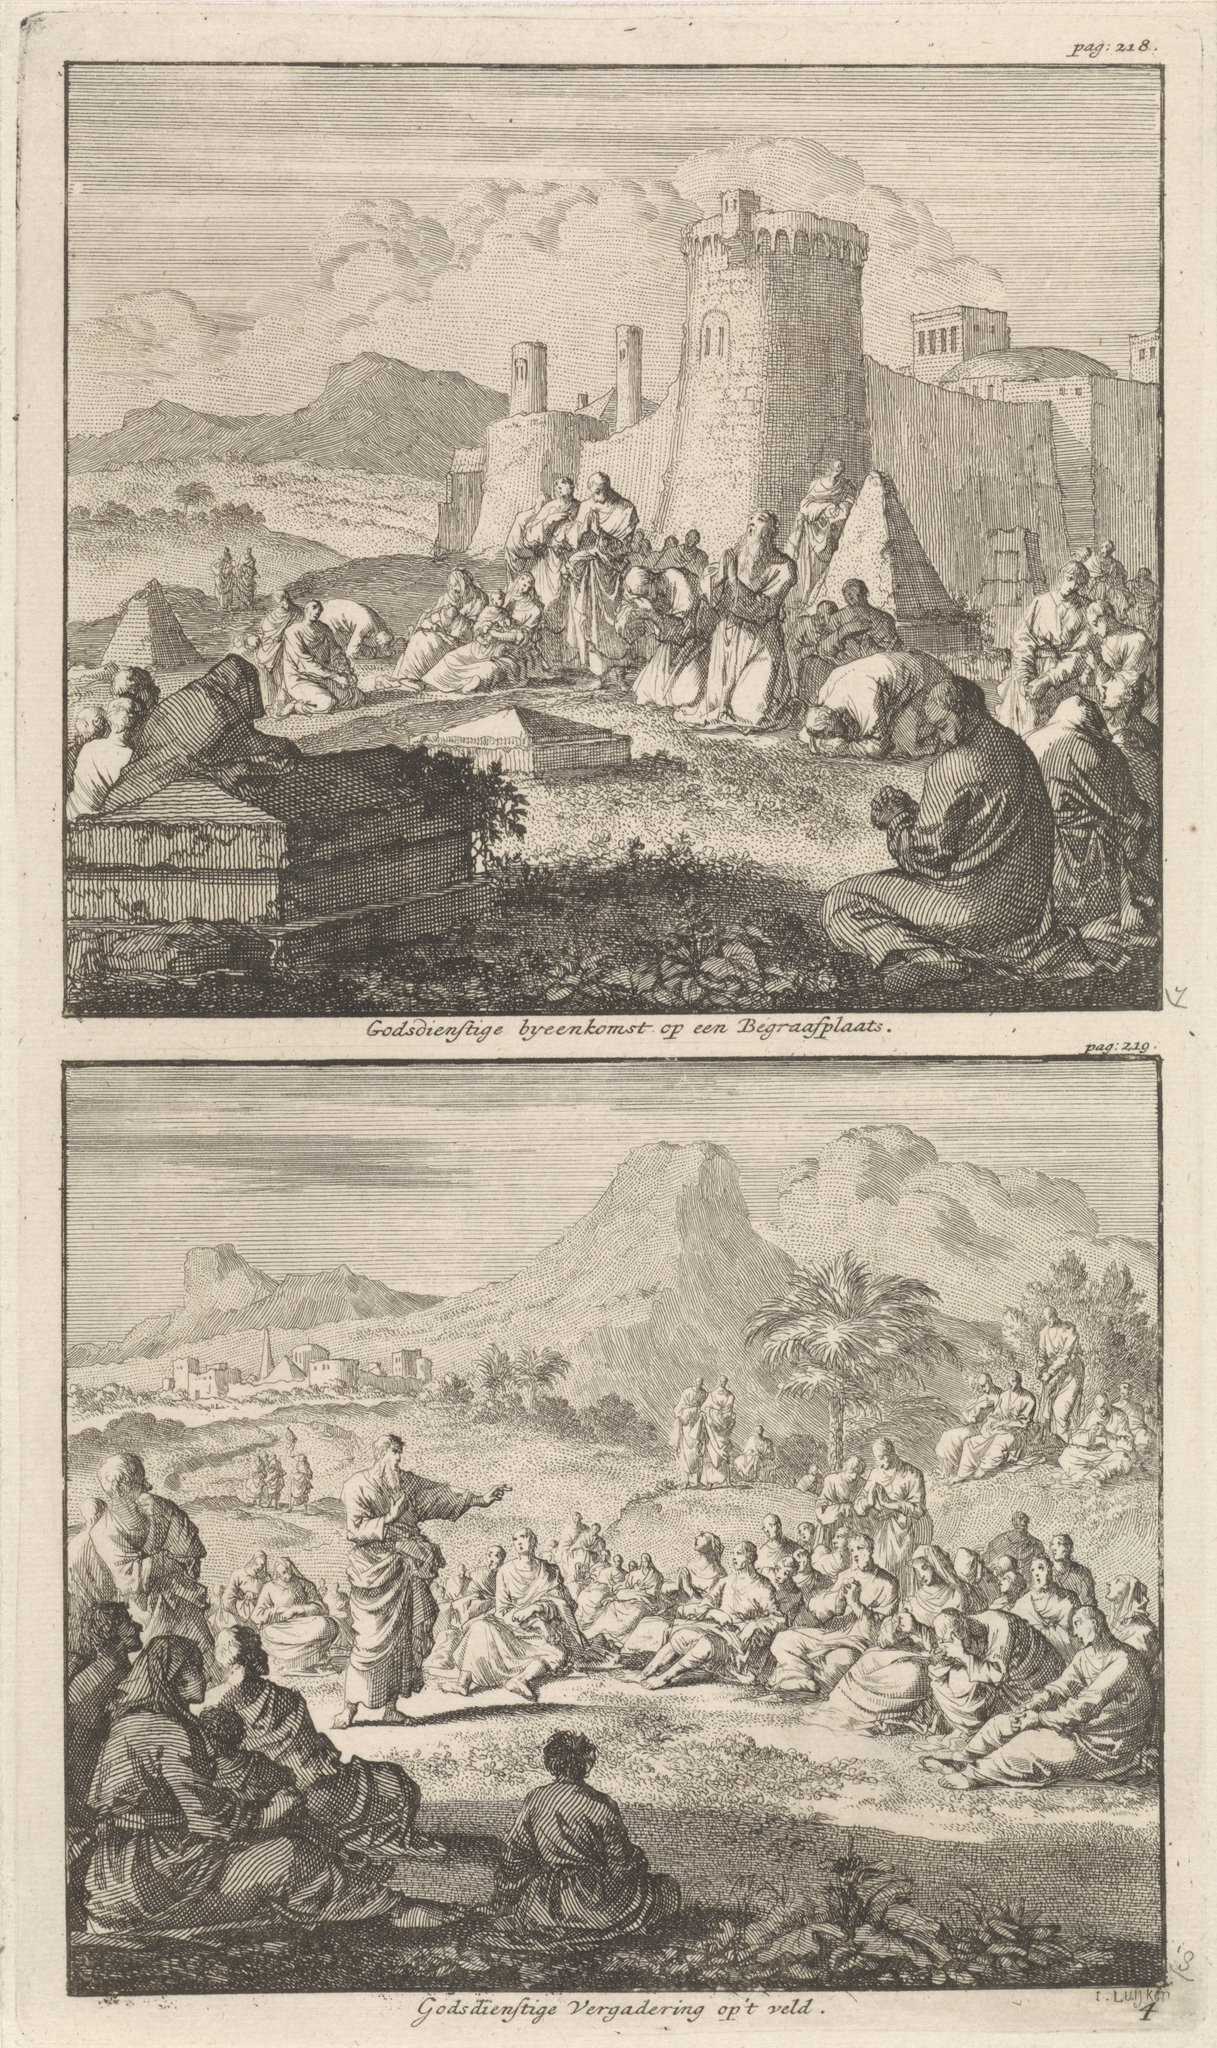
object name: print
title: Godsdienstige byeenkomst op een Begraafplaats / Godsdienstige Vergadering op 't veld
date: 1700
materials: paper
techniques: etching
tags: the early christian churches, e.g. armenians, copts, syrians, (public) prayer, city-view in general; 'veduta', city-walls, preaching (in general), churchyard, cemetery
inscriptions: collector's mark: Lugt 2228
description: Twee voorstellingen op een plaat. Boven: vroege Christenen komen samen bij een begraafplaats buiten een stad. Ze zitten knielend te bidden. Op de achtergrond de stadsmuren. Onder: vroege Christenen zitten in de wildernis rondom een prediker en luisteren naar zijn woorden. Op de achtergrond een stad.